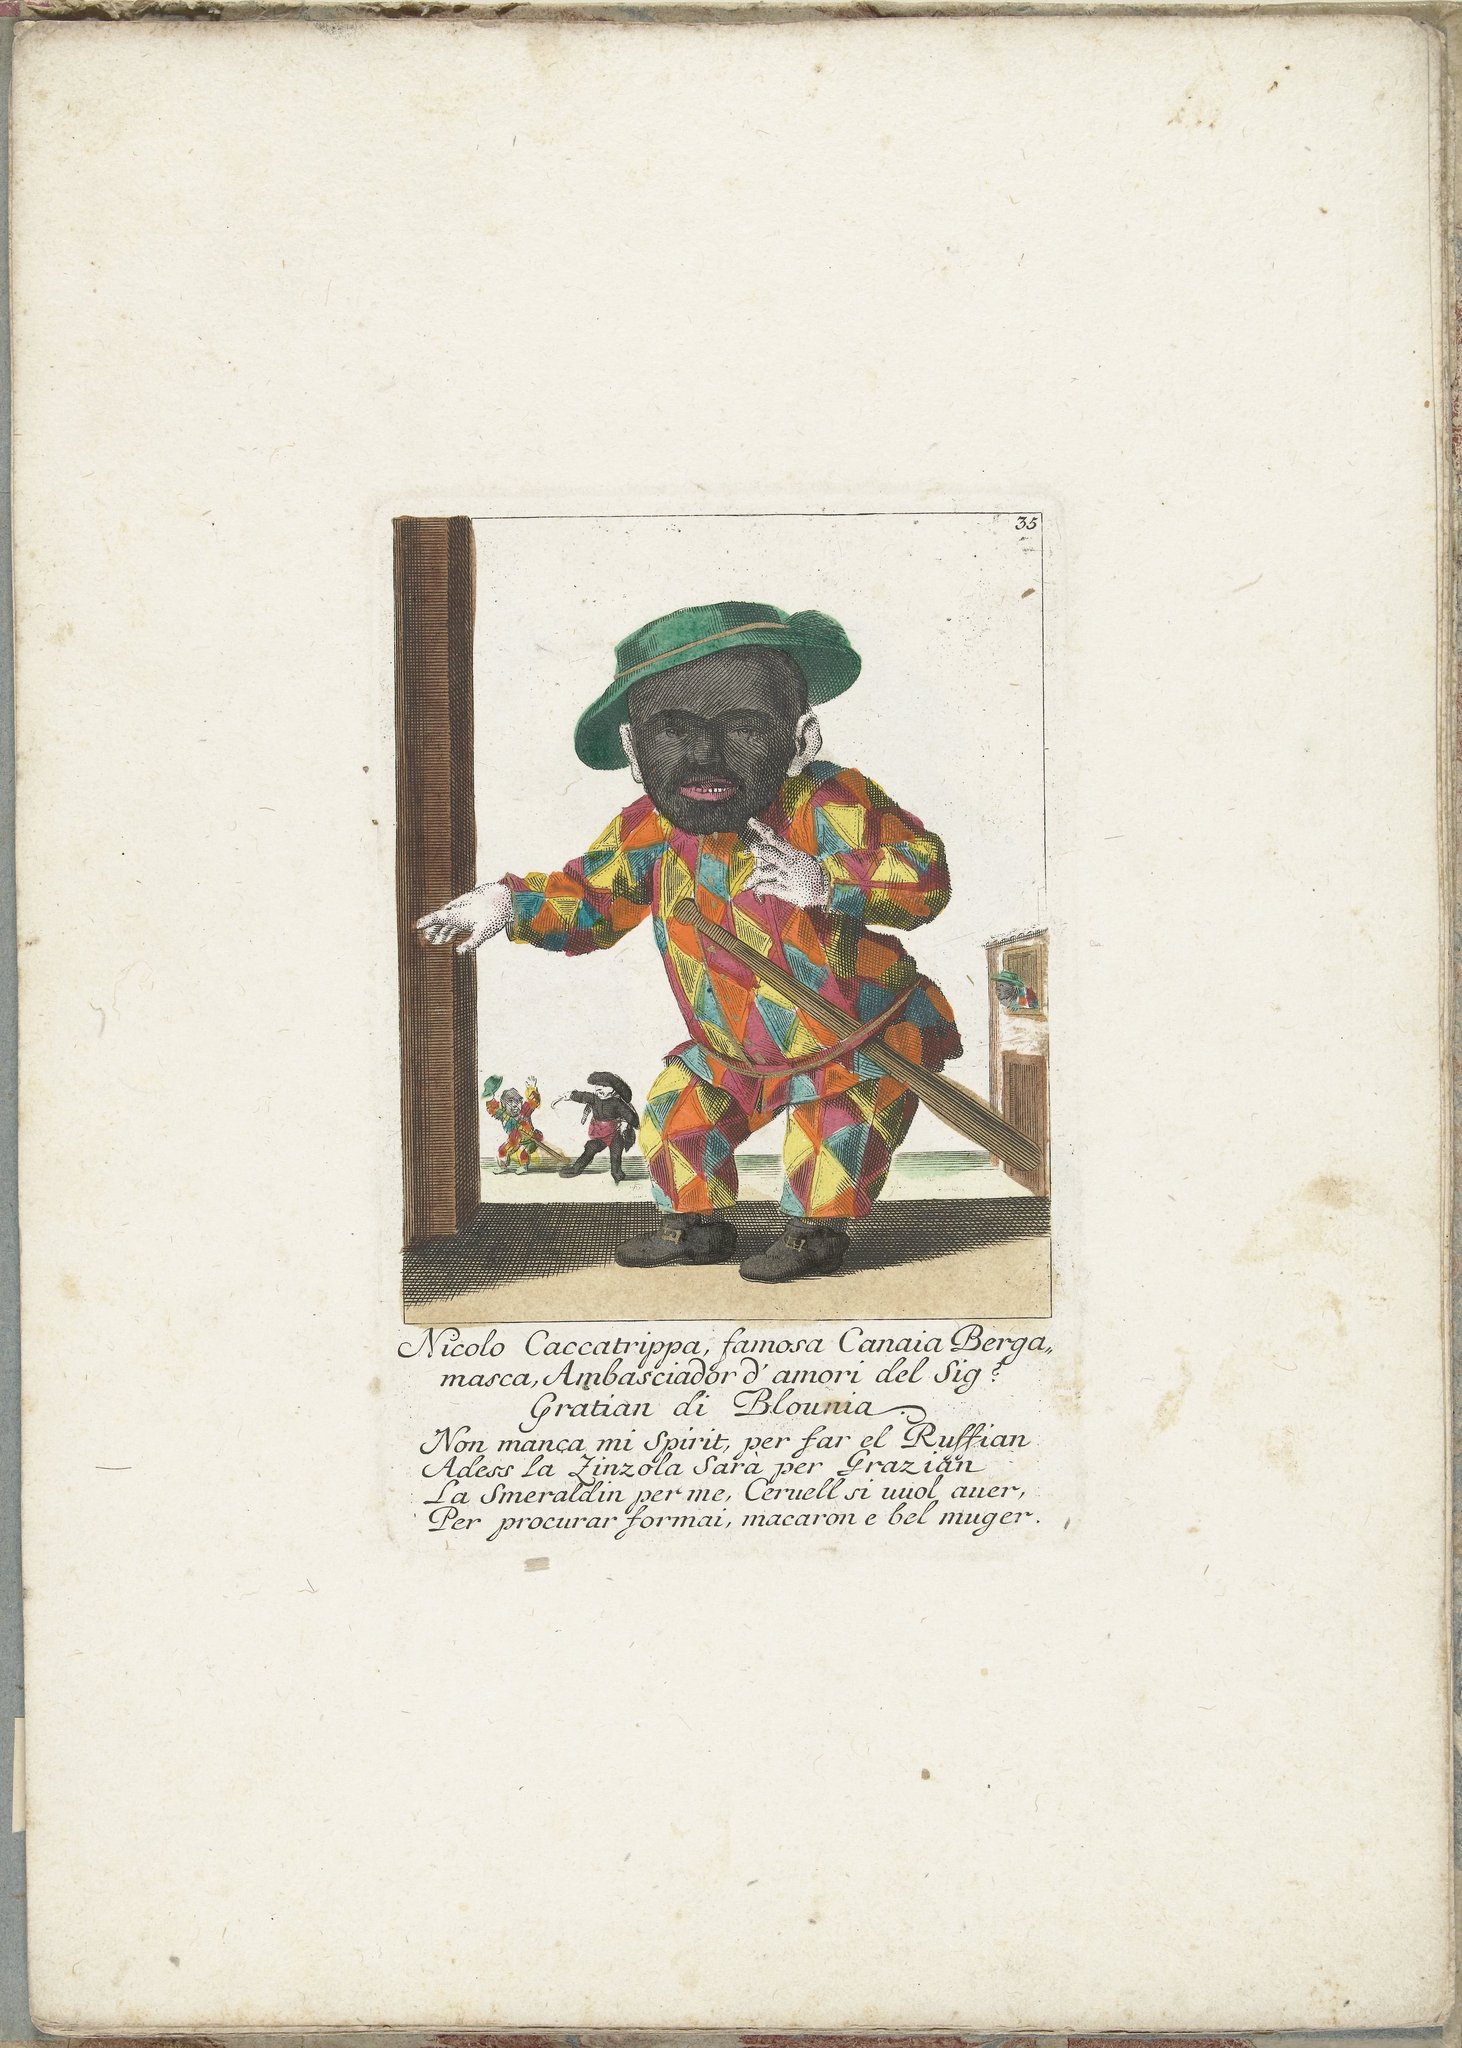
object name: caricature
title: Il Callotto resurcitato oder Neu eingerichtes Zwerchen Cabinet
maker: martin engelbrecht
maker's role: print maker, publisher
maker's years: 1684-1756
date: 1705-1715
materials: paper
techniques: engraving, hand coloring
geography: augsburg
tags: caricatures (human types), little people, types in 'commedia dell'arte': harlequin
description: De Italiaanse kleine mens Nicolo Caccatrippa als harlekijn met een zwart masker. In het onderschrift onder de titel een vierregelig vers in het Italiaans. Genummerd rechtsboven: 35. Onderdeel van een losbladige uitgave uit ca. 1710 van een serie karikaturen van kleine mensen, bekend als Het Dwergentooneel.